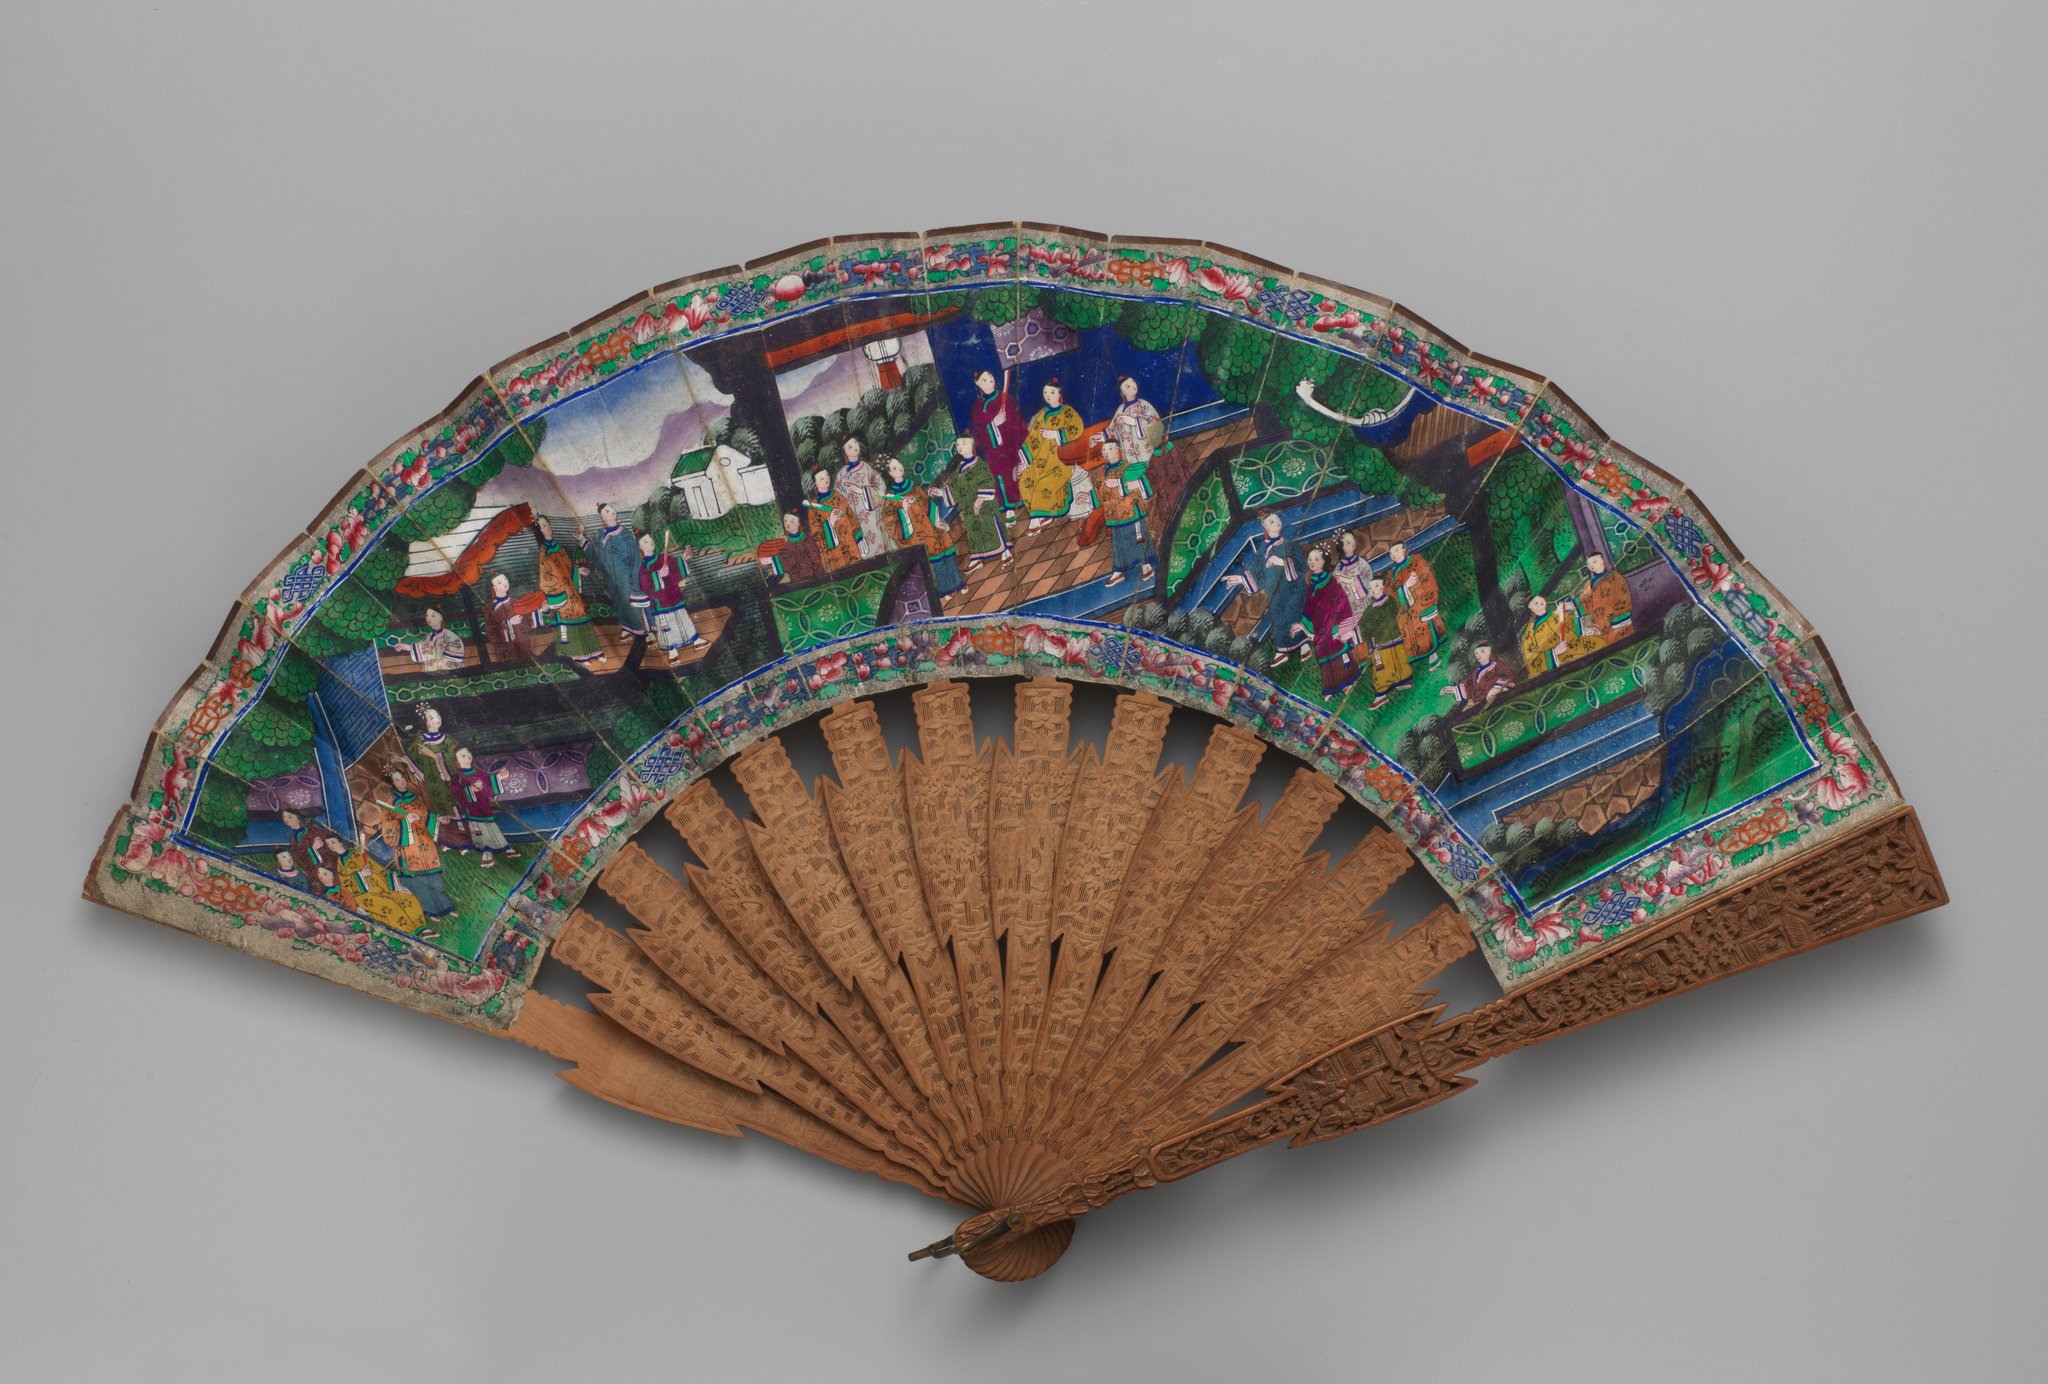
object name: fan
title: Folding Fan with Scene of Figures in a Courtyard Garden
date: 1801-1900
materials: paper, wood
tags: men,women